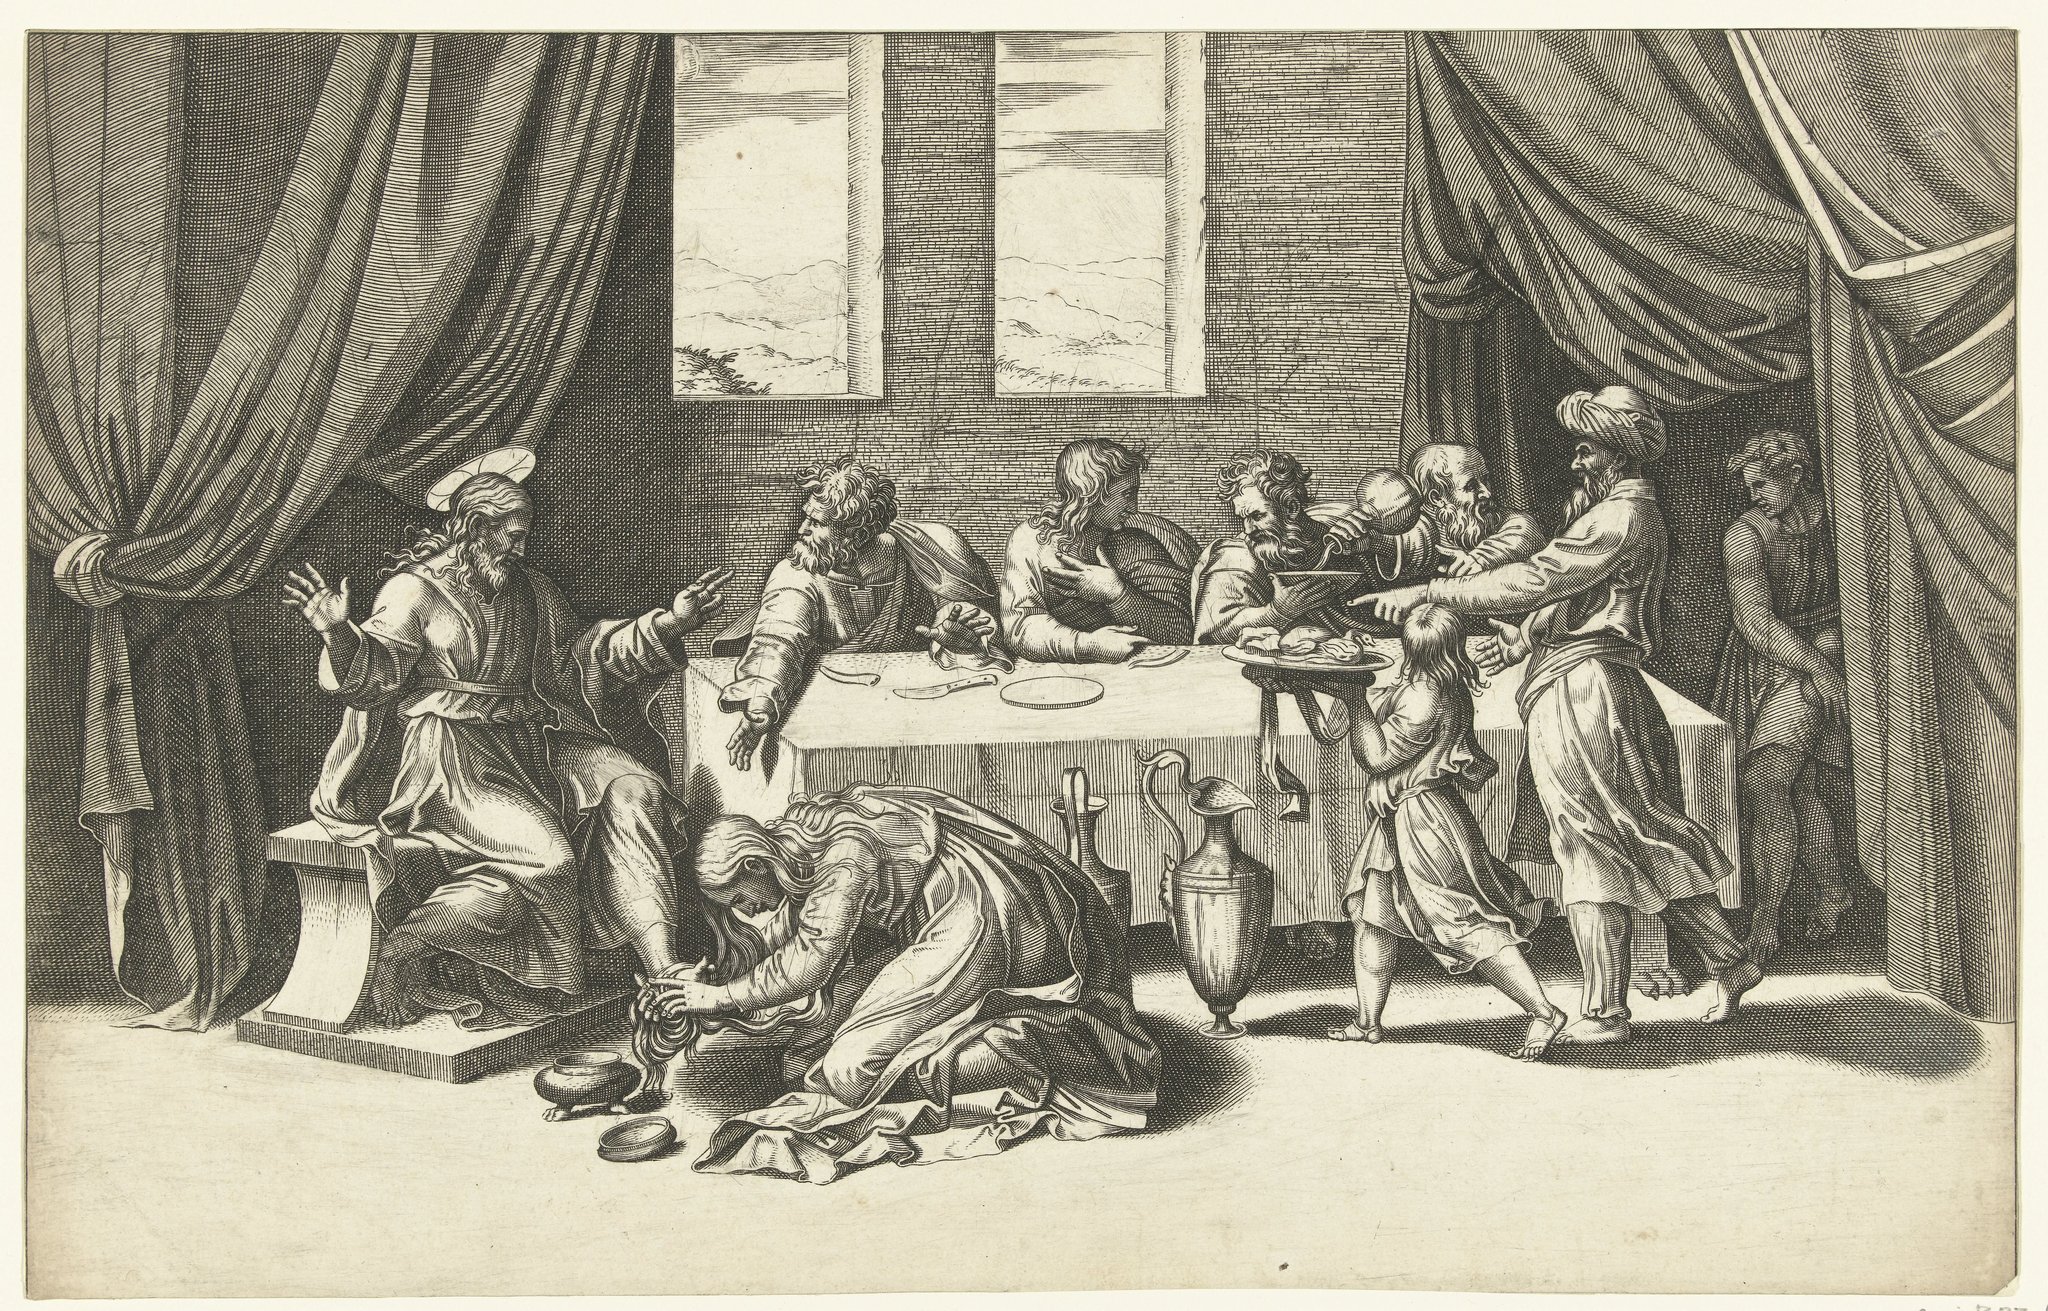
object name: print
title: Christus in huis van Simon de Farizeeër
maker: Anonymous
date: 1520-1575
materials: paper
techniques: engraving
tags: a woman washes christ's feet with her tears, and wipes them with her hair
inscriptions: collector's mark: Lugt 240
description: Kopie naar prent van Marcantonio Raimondi. Raimondi baseerde zich op fresco's welke zich oorspronkelijk in de S. Trinità dei Monti te Rome bevonden, van de hand van Giulio Romano en Giovanni Francesco Penni (Shoemaker 1981, p. 174).